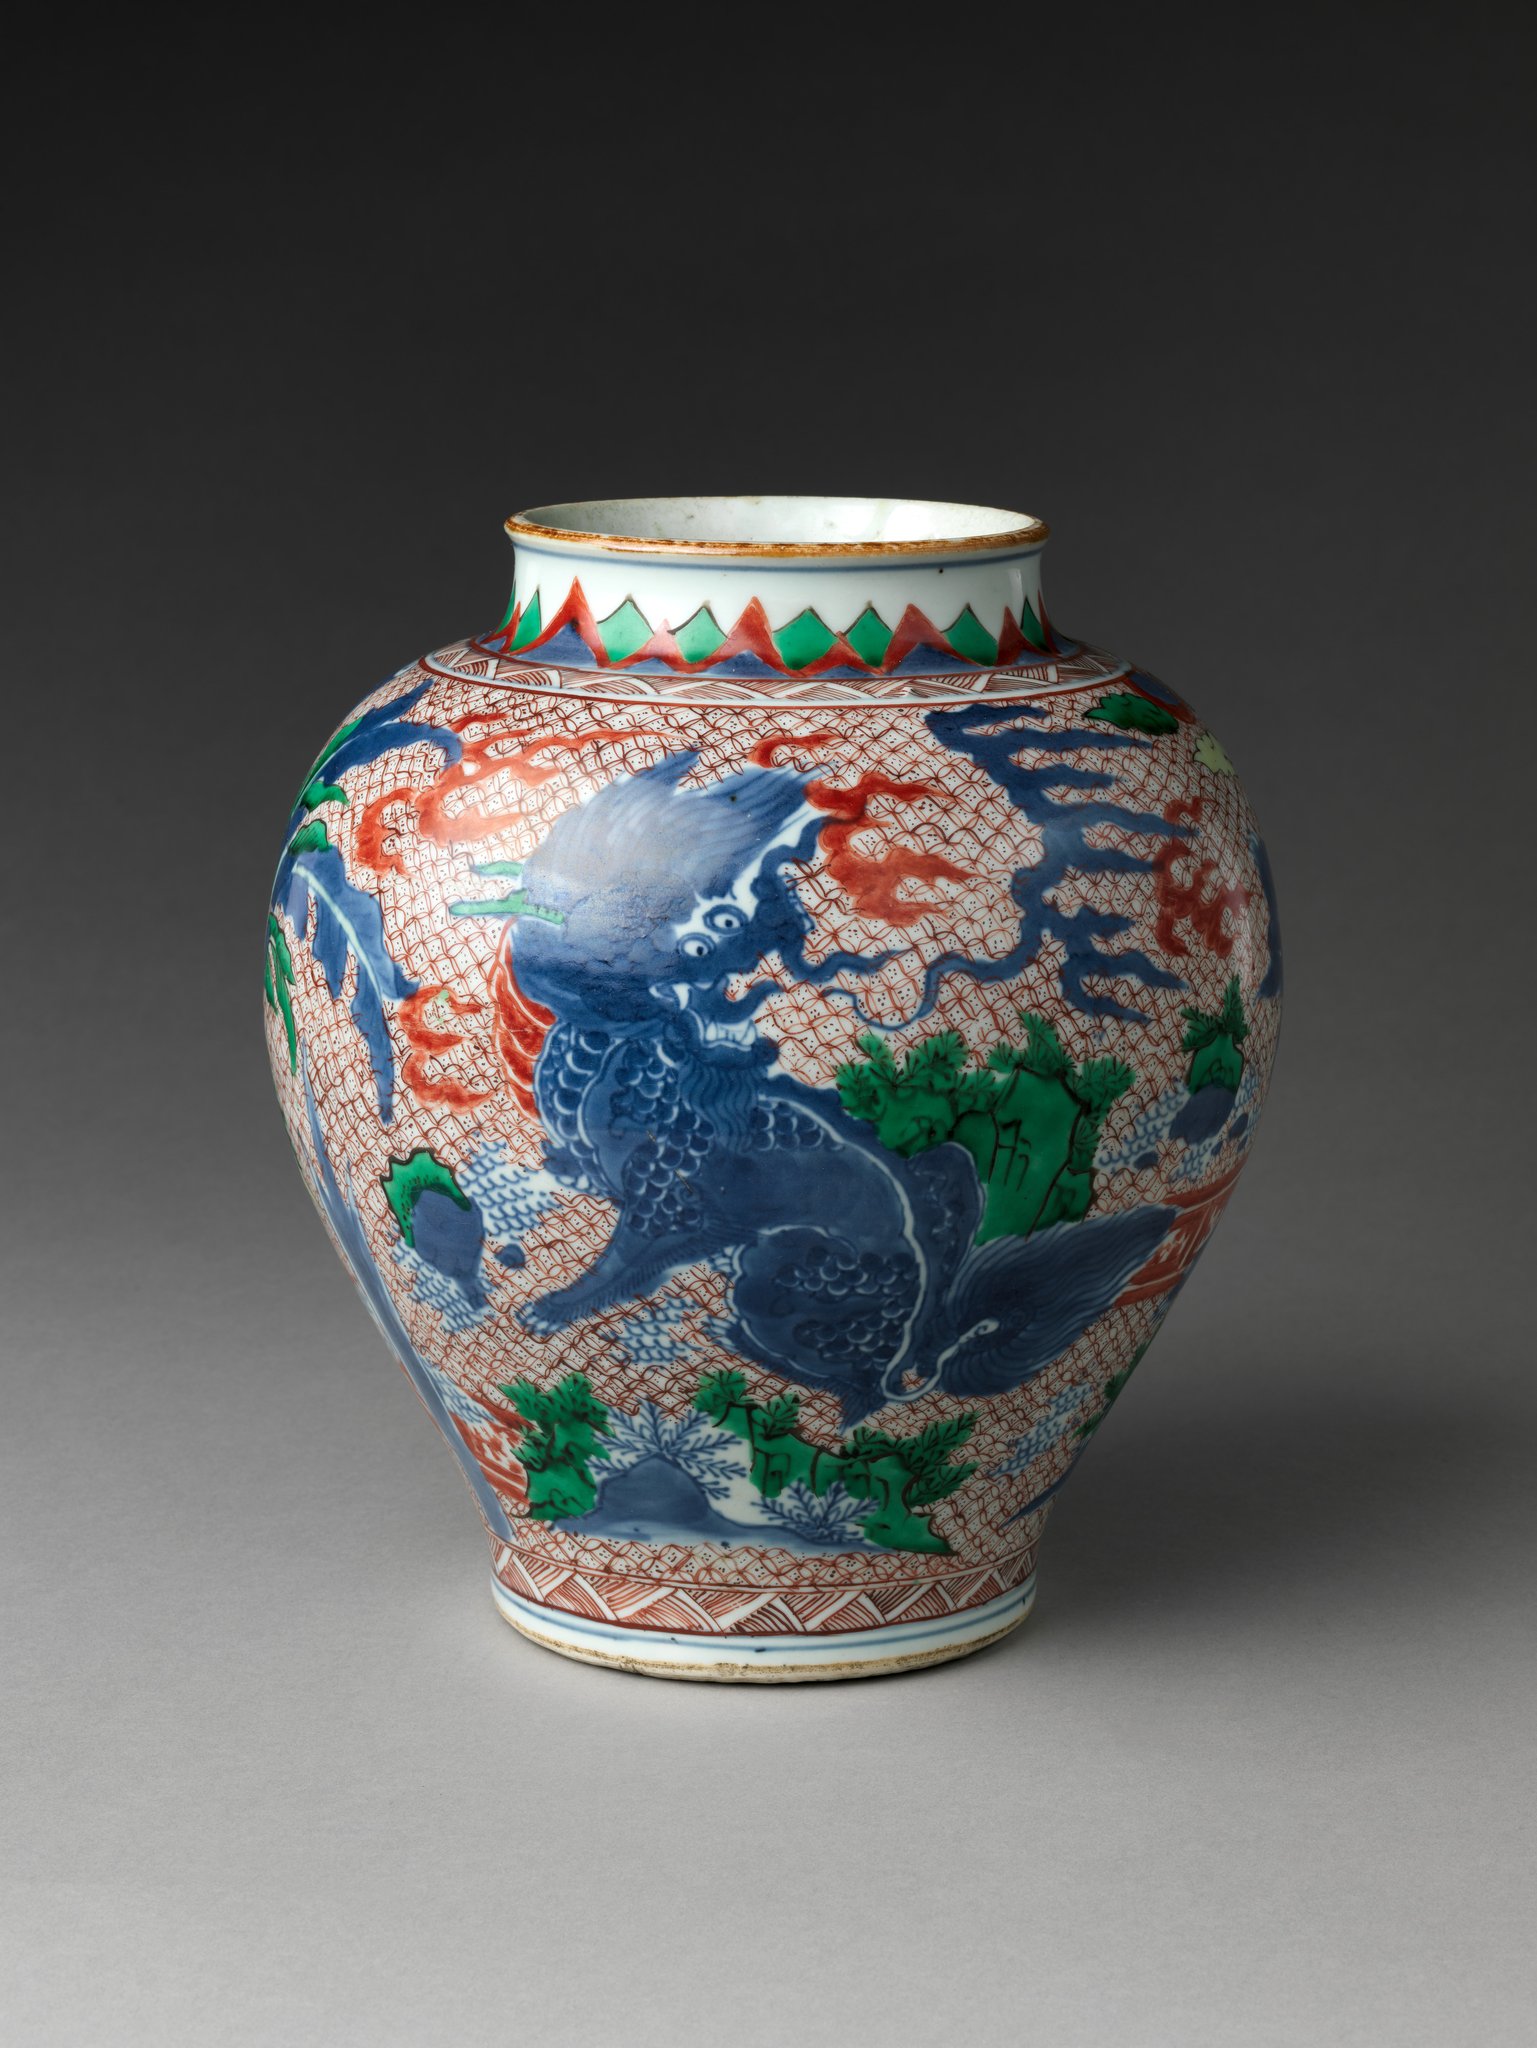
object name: jar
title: Jar with Mythical Qilin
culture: chinese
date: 1634-1666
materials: enamel, glaze, porcelain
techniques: painting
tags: mythical creatures,trees